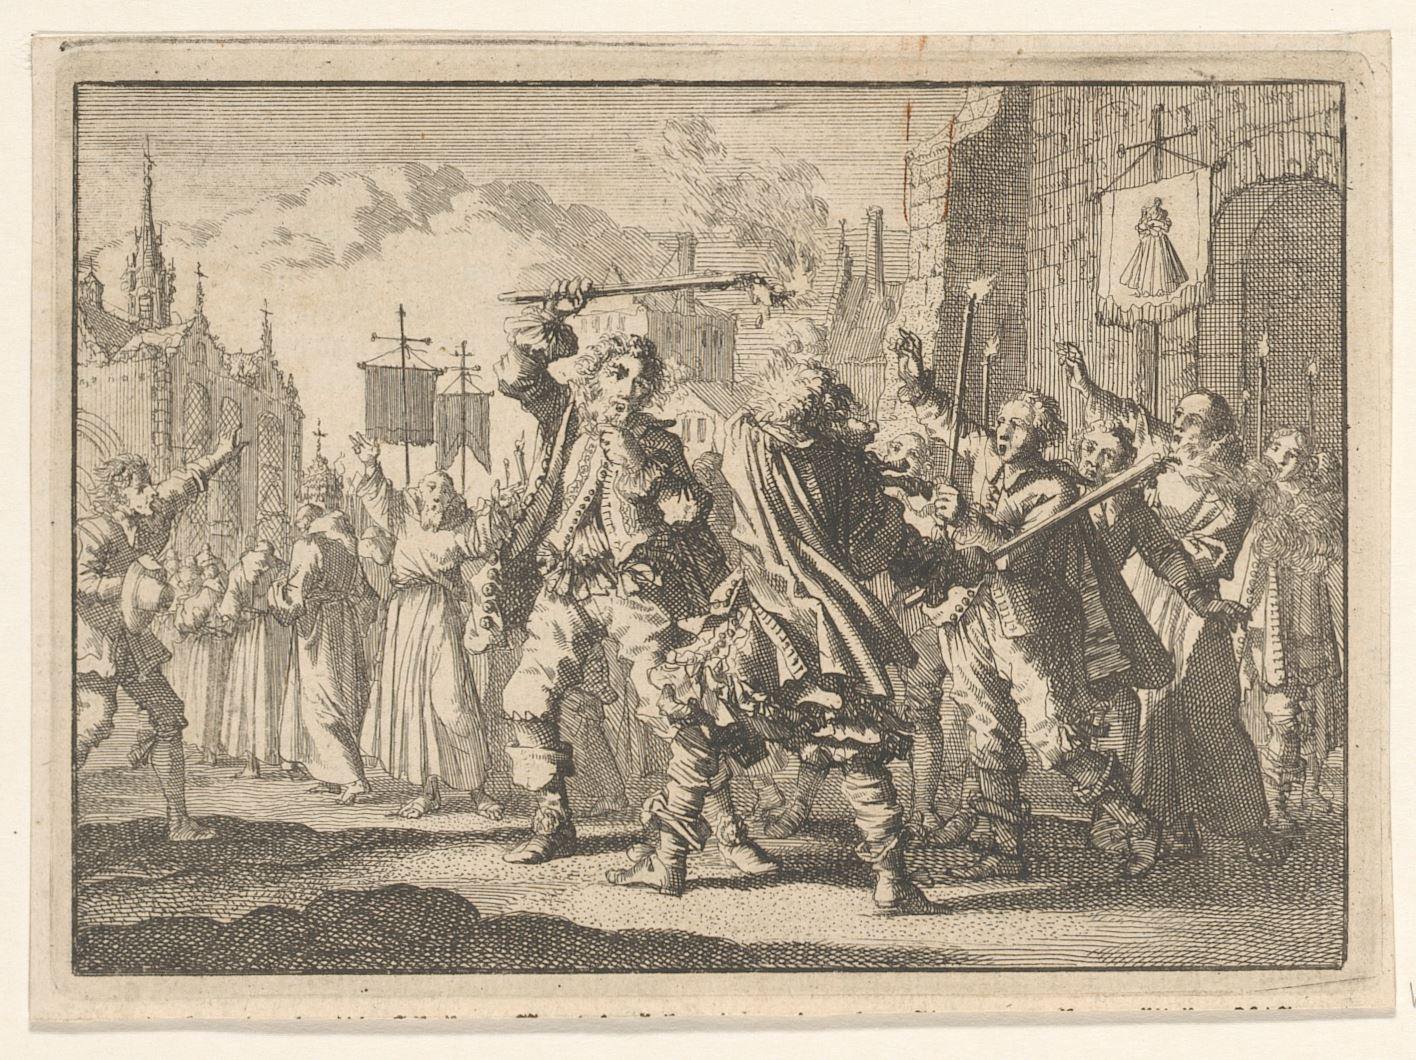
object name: print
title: Twist te Presburg tussen inwoners van Mantua en Genua over voorrang in een processie, 1655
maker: jan luyken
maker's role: draughtsman, print maker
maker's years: 1649-1712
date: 1698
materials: paper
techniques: etching, letterpress printing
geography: amsterdam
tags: procession ~ christian religion, fighting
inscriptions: collector's mark: Lugt 2228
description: Illustratie genomen uit: Johann Ludwig Gottfried, Historische kronyck; vervattende een (...) beschrijvingh der aldergedenckwaerdigste geschiedenissen des weerelds, van den aenvangh der scheppingh tot (...) 1576 (2 delen). Leiden: Pieter van der Aa, 1698, dl. II, p. 111.